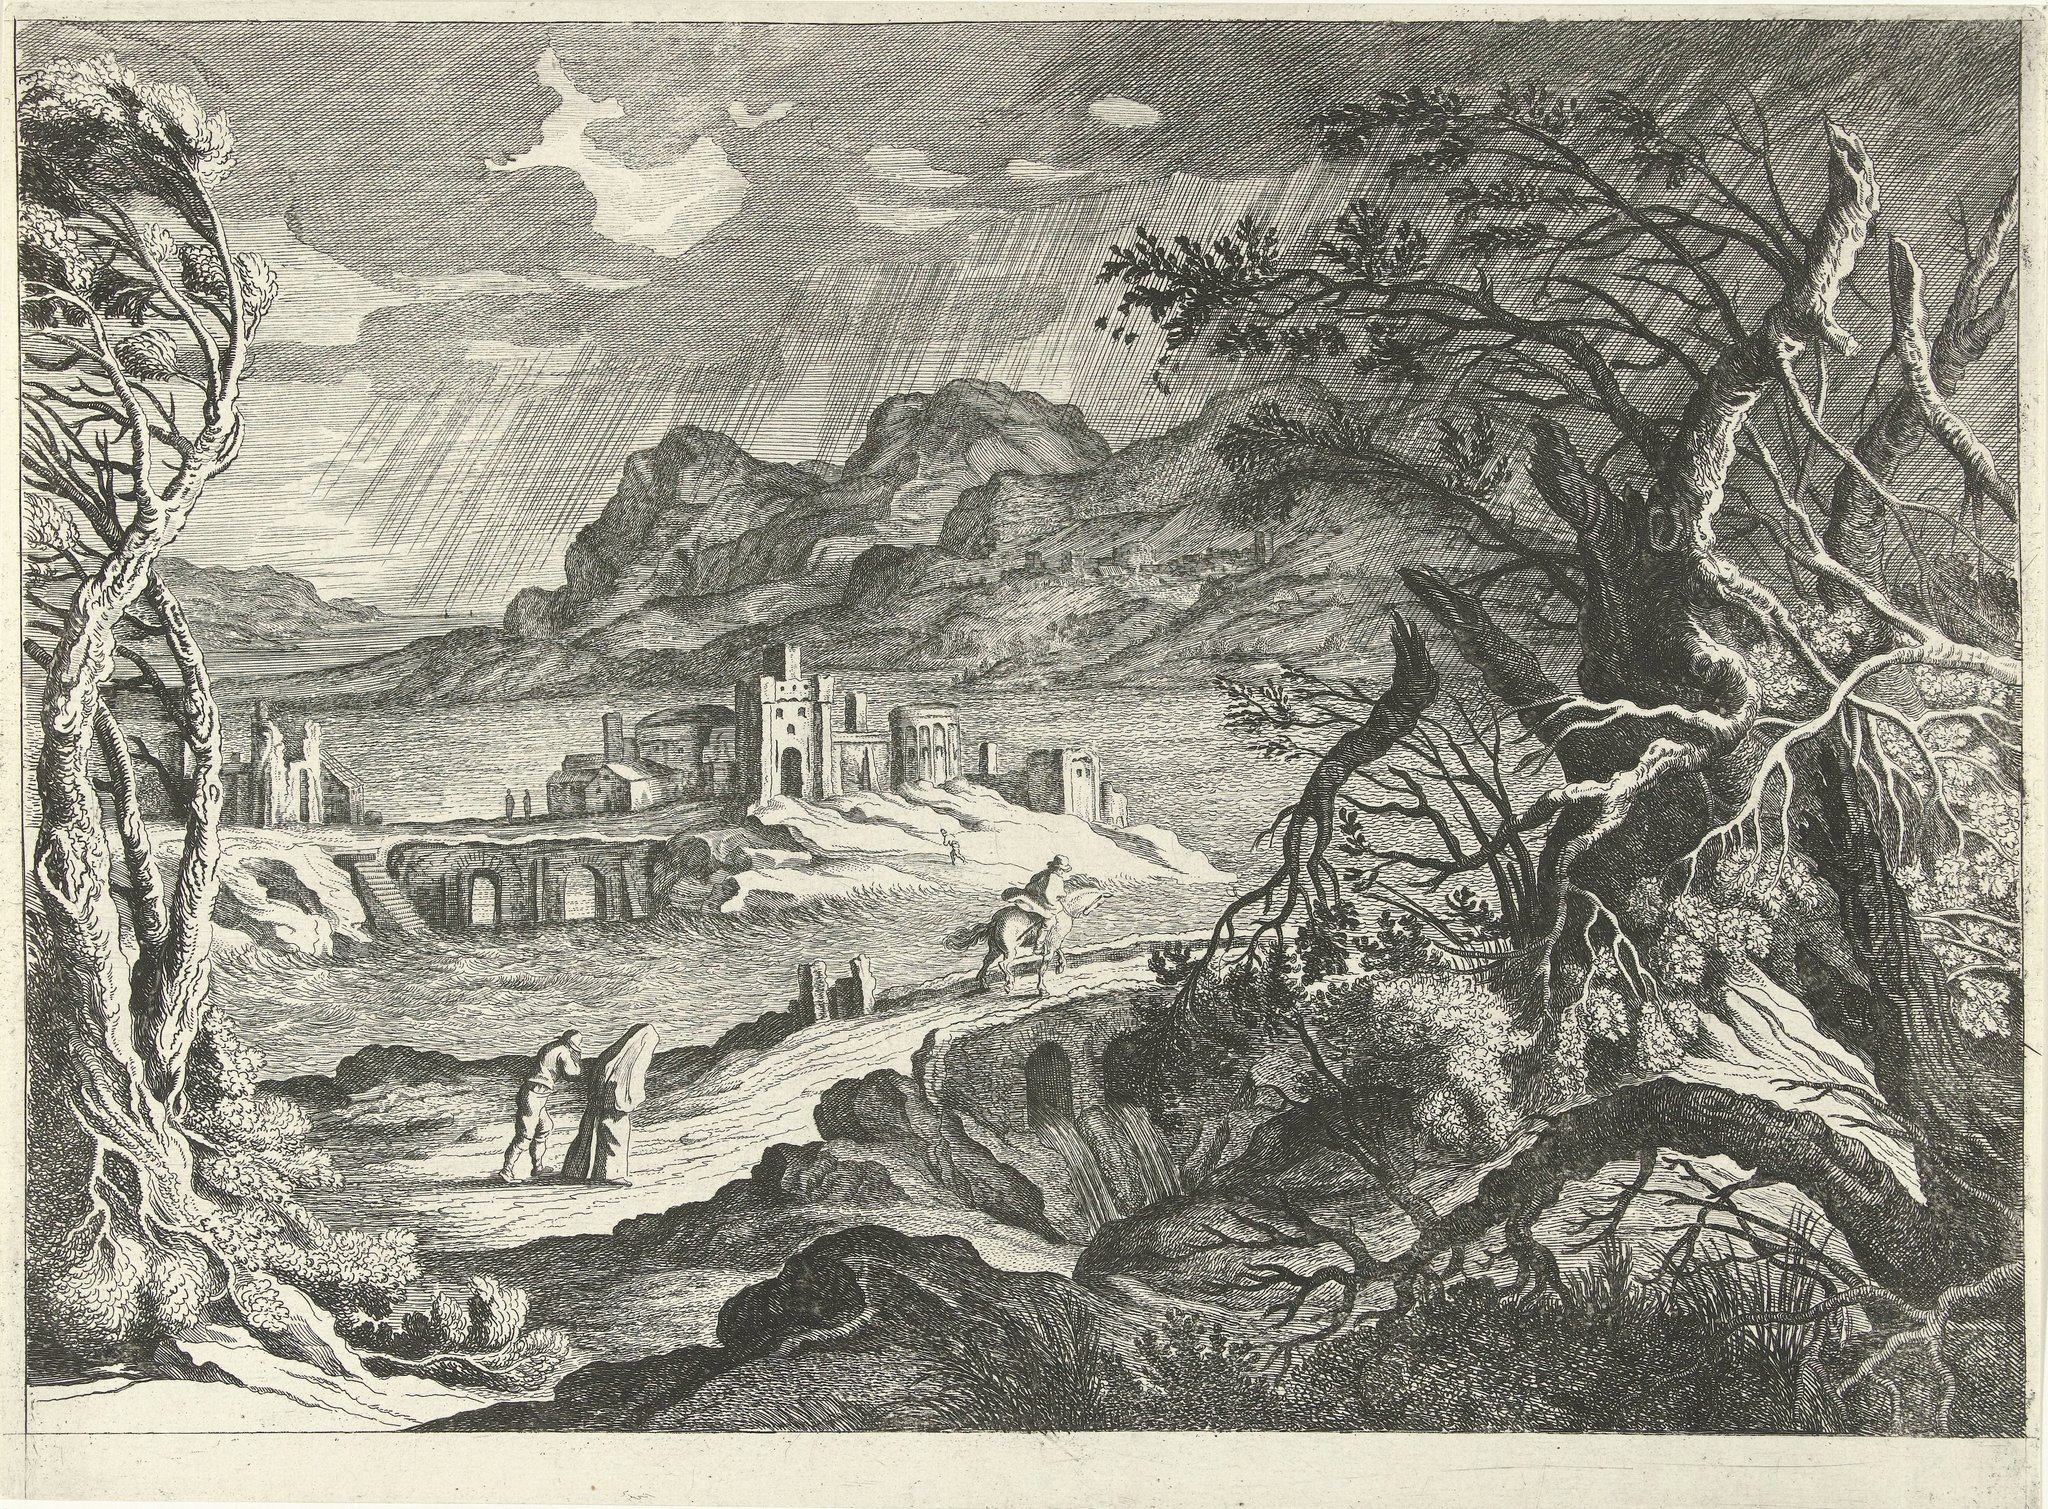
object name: print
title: Italiaanse landschappen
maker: willem van de lande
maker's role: print maker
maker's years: 1610-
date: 1635-1650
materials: paper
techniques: etching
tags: storm, landscape with ruins - ii - ideal landscapes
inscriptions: collector's mark: Lugt 2228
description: Italiaans landschap met figuren in de storm, in de verte ruïnes en een nederzetting. De prent maakt deel uit van een zesdelige serie prenten met Italiaanse landschappen.